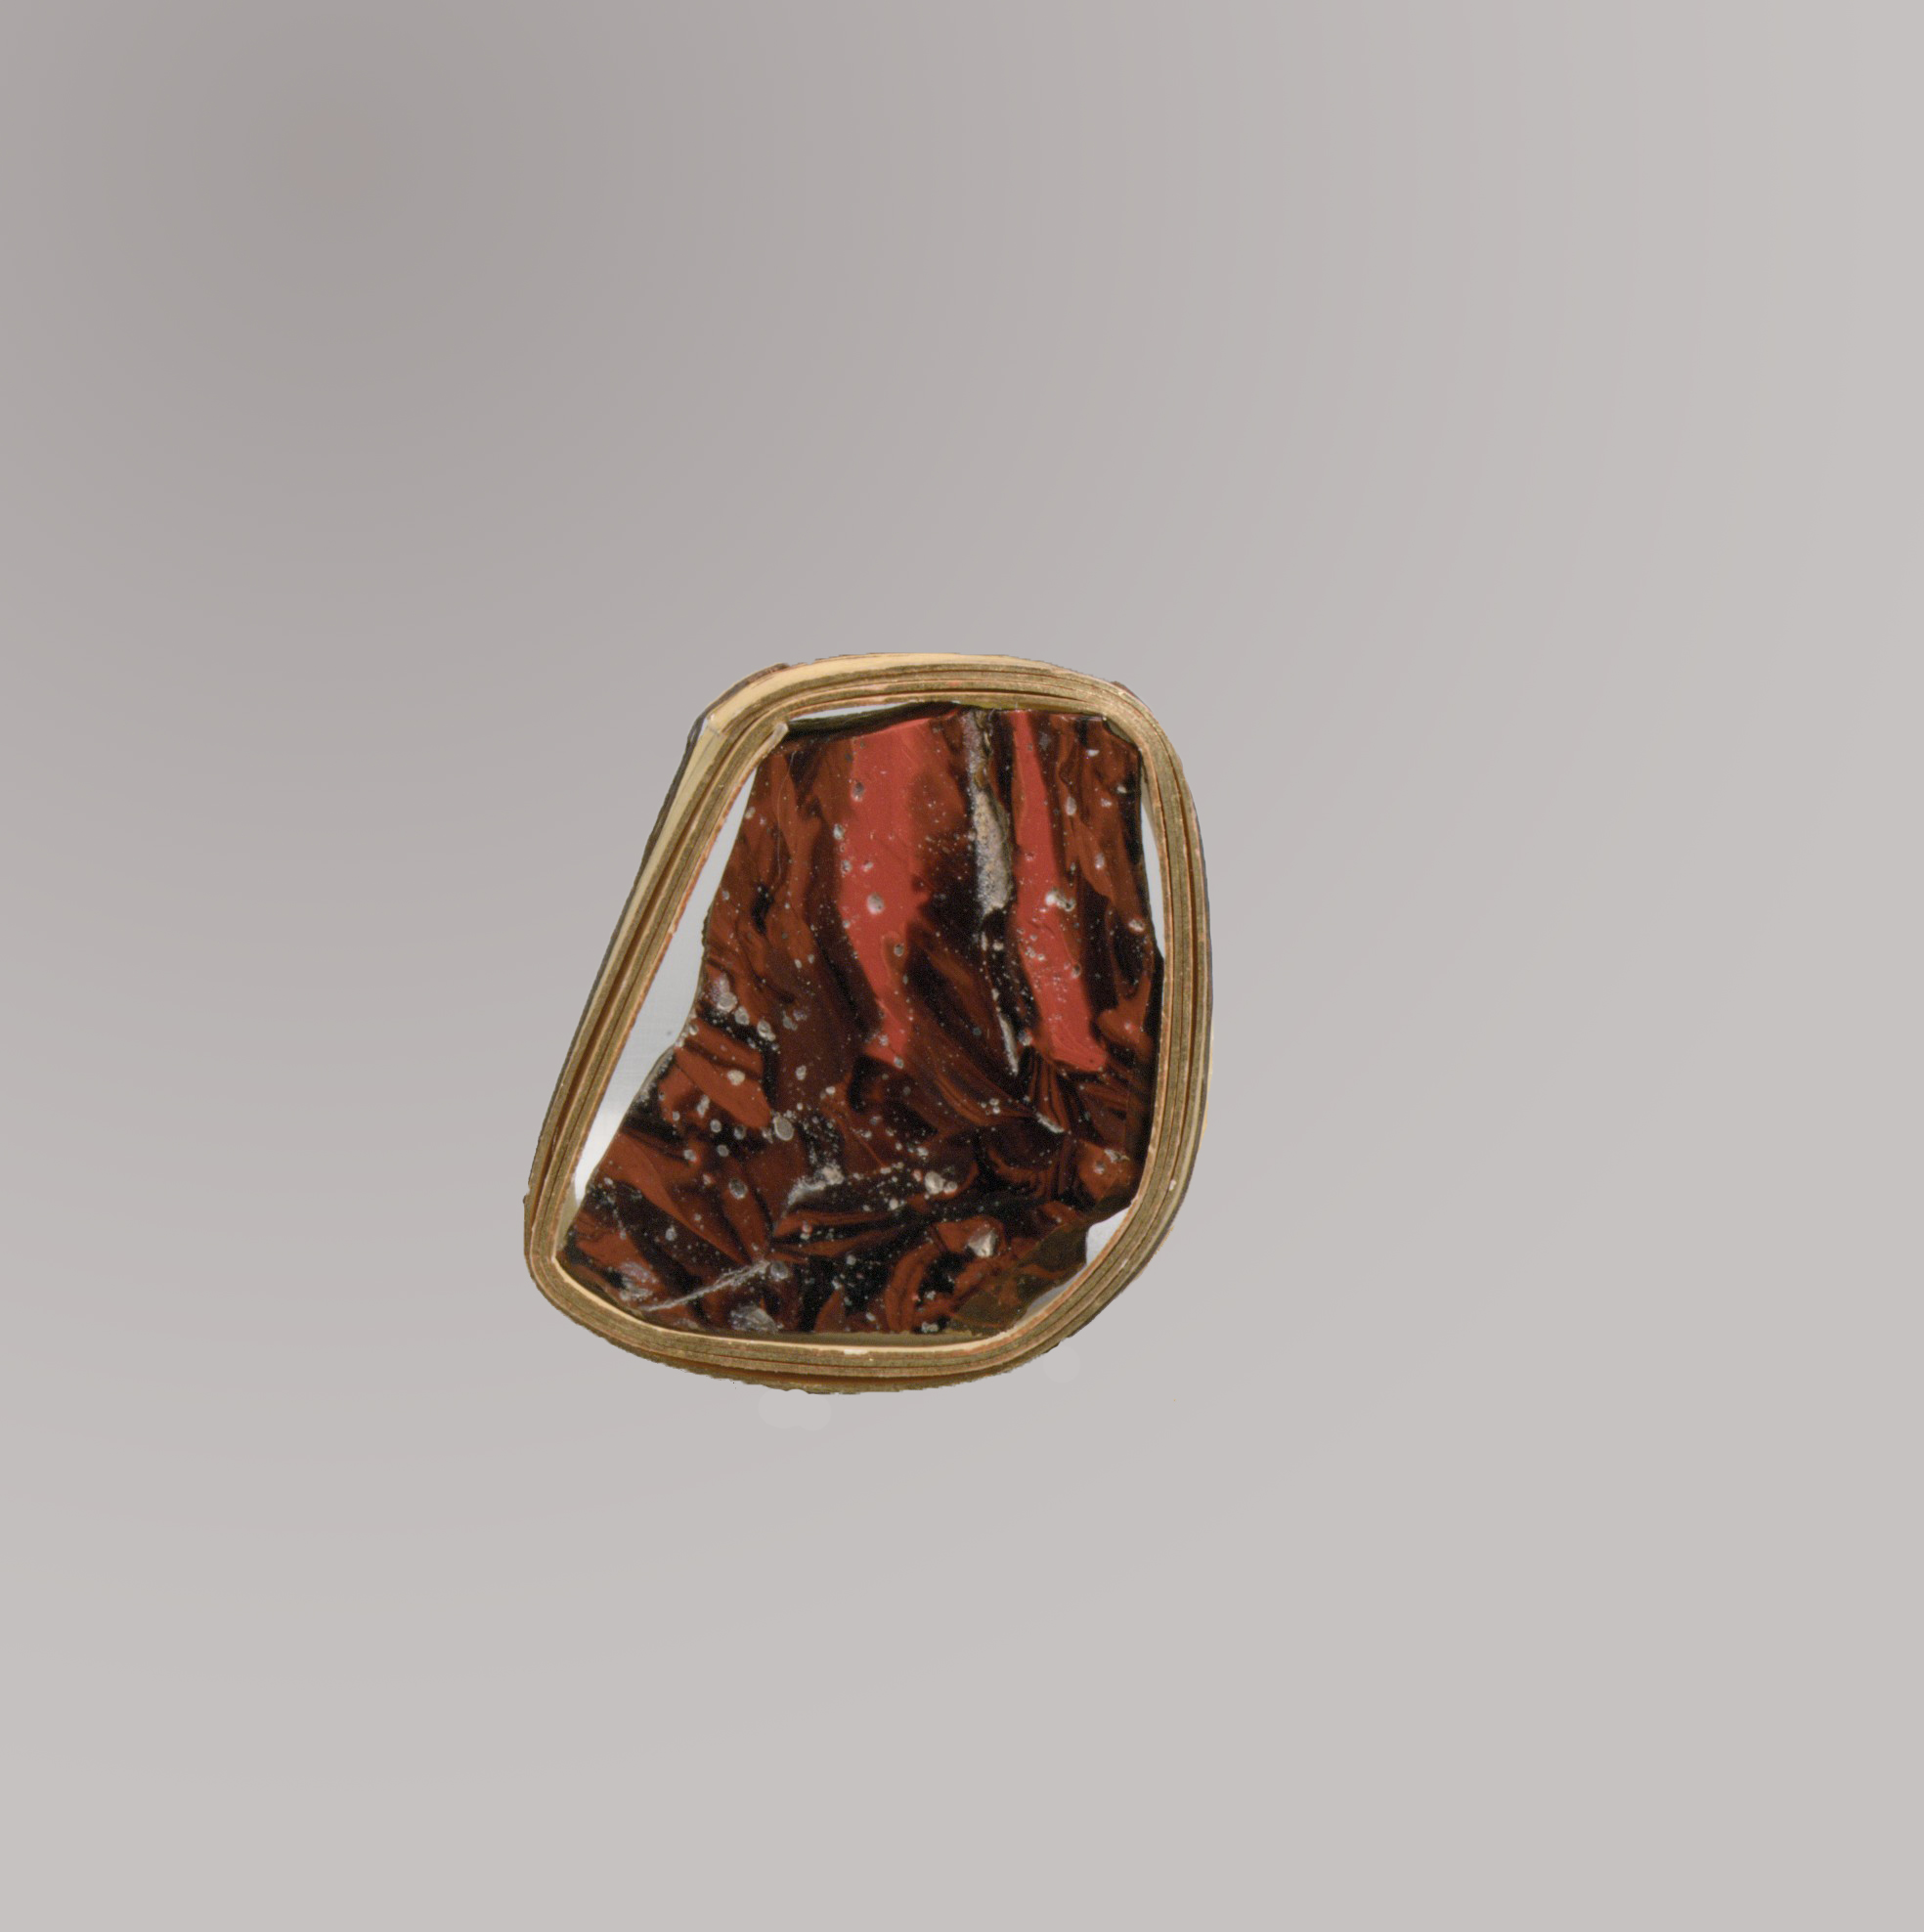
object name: fragment, mosaic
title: Glass mosaic inlay fragment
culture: roman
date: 34 BCE-33 CE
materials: glass